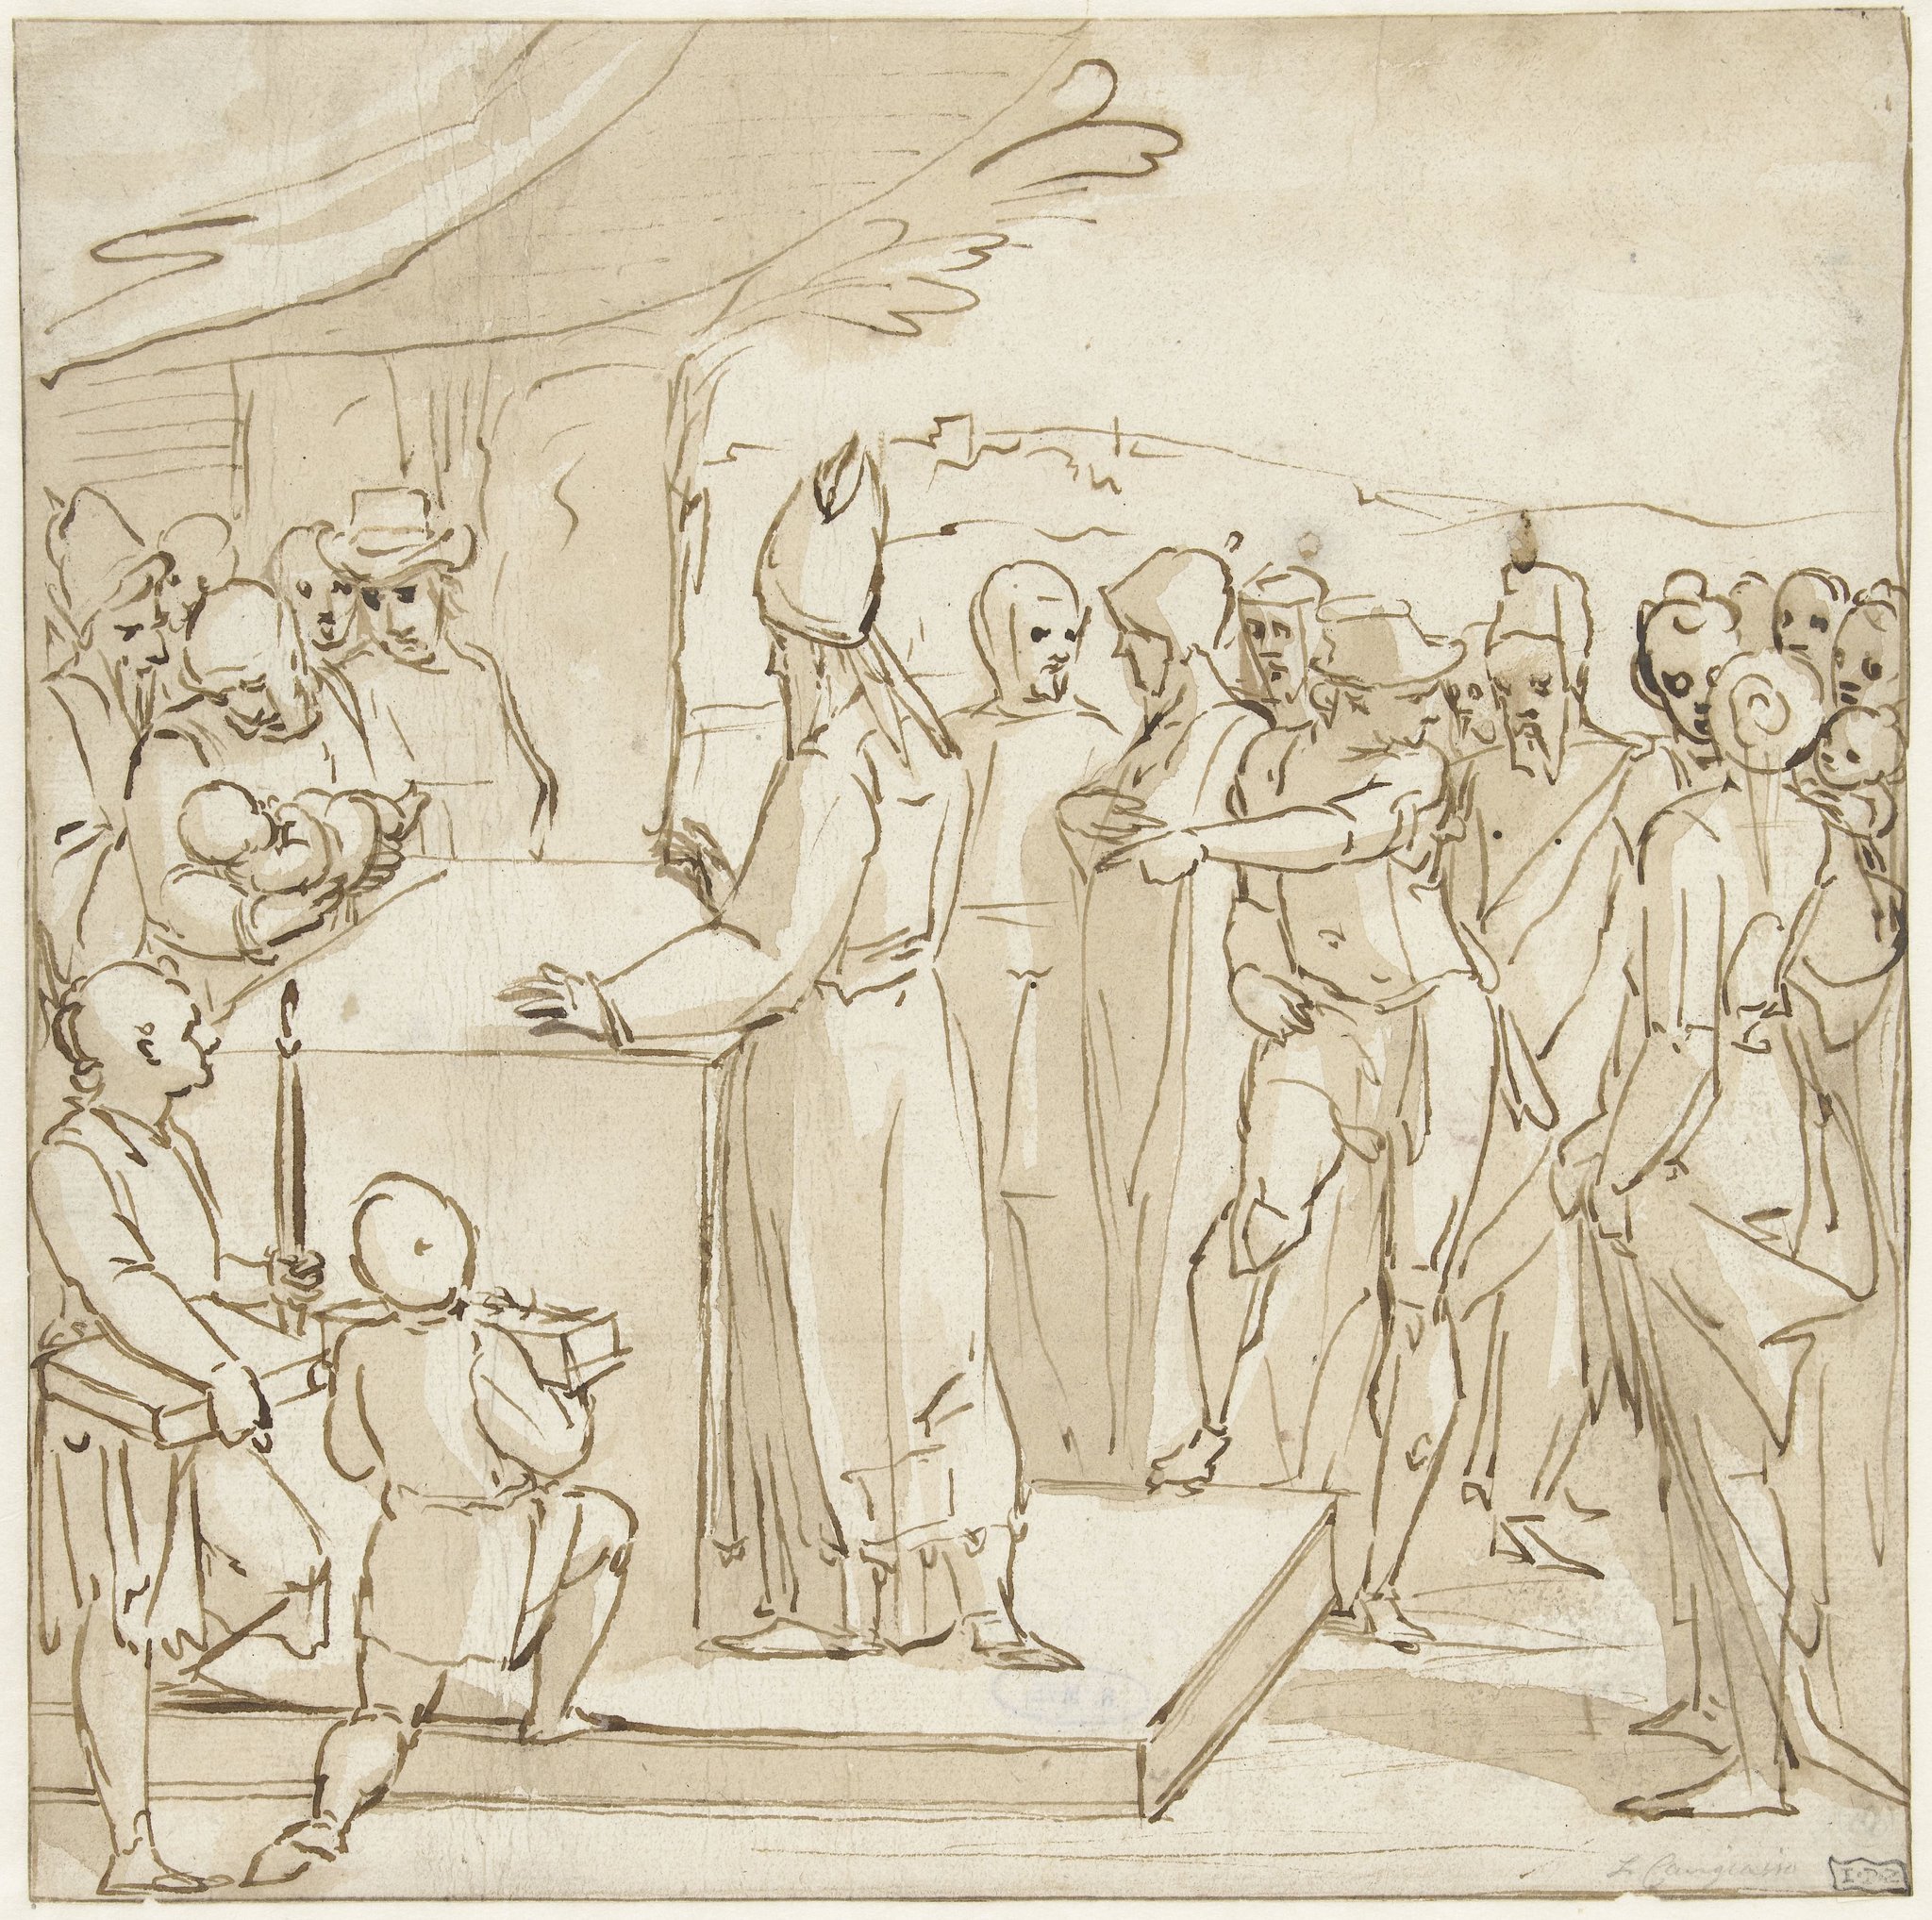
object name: drawing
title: Opdracht in de tempel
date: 1540-1620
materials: ink, paper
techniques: brush, pen